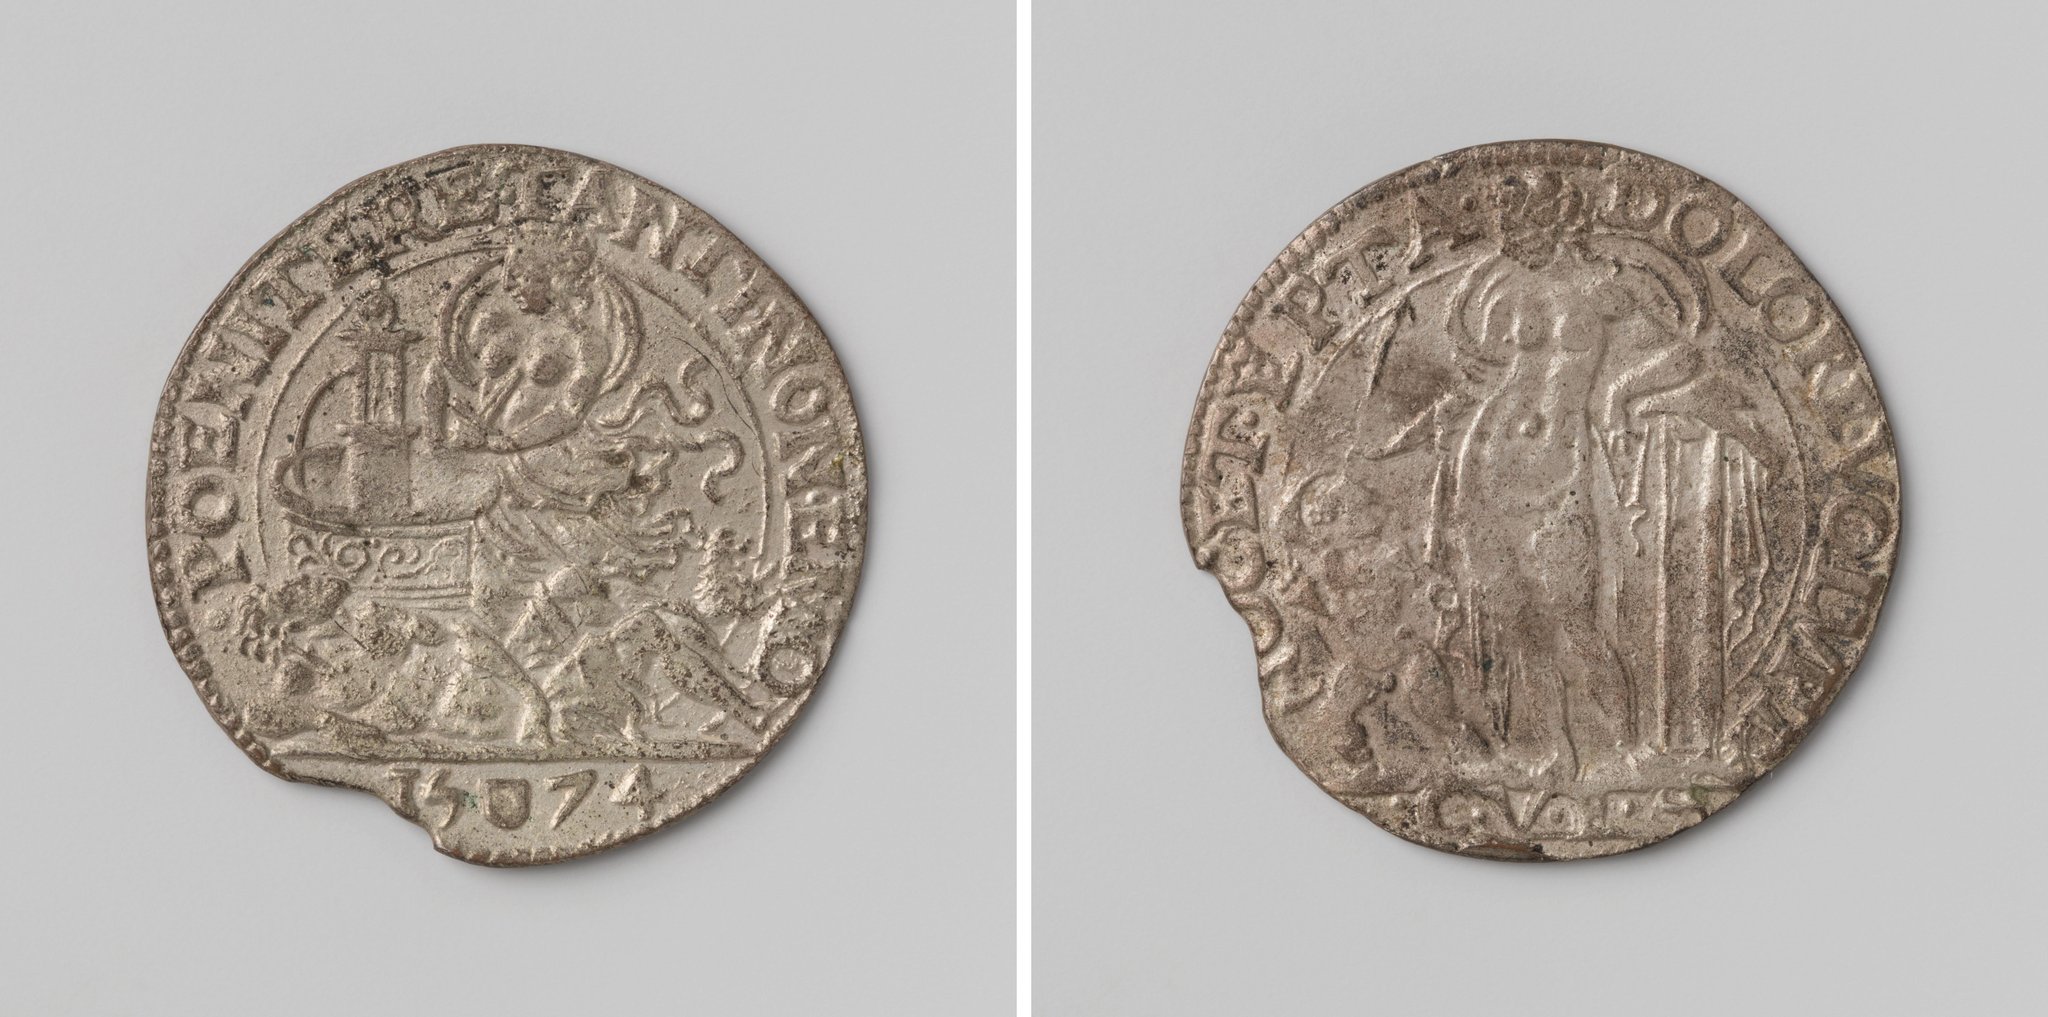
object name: jeton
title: Rekenpenning geslagen op last van de Staten van Utrecht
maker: Anonymous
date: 1574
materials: copper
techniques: striking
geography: utrecht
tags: utrecht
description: Penning geslagen op last van de Staten van Utrecht.